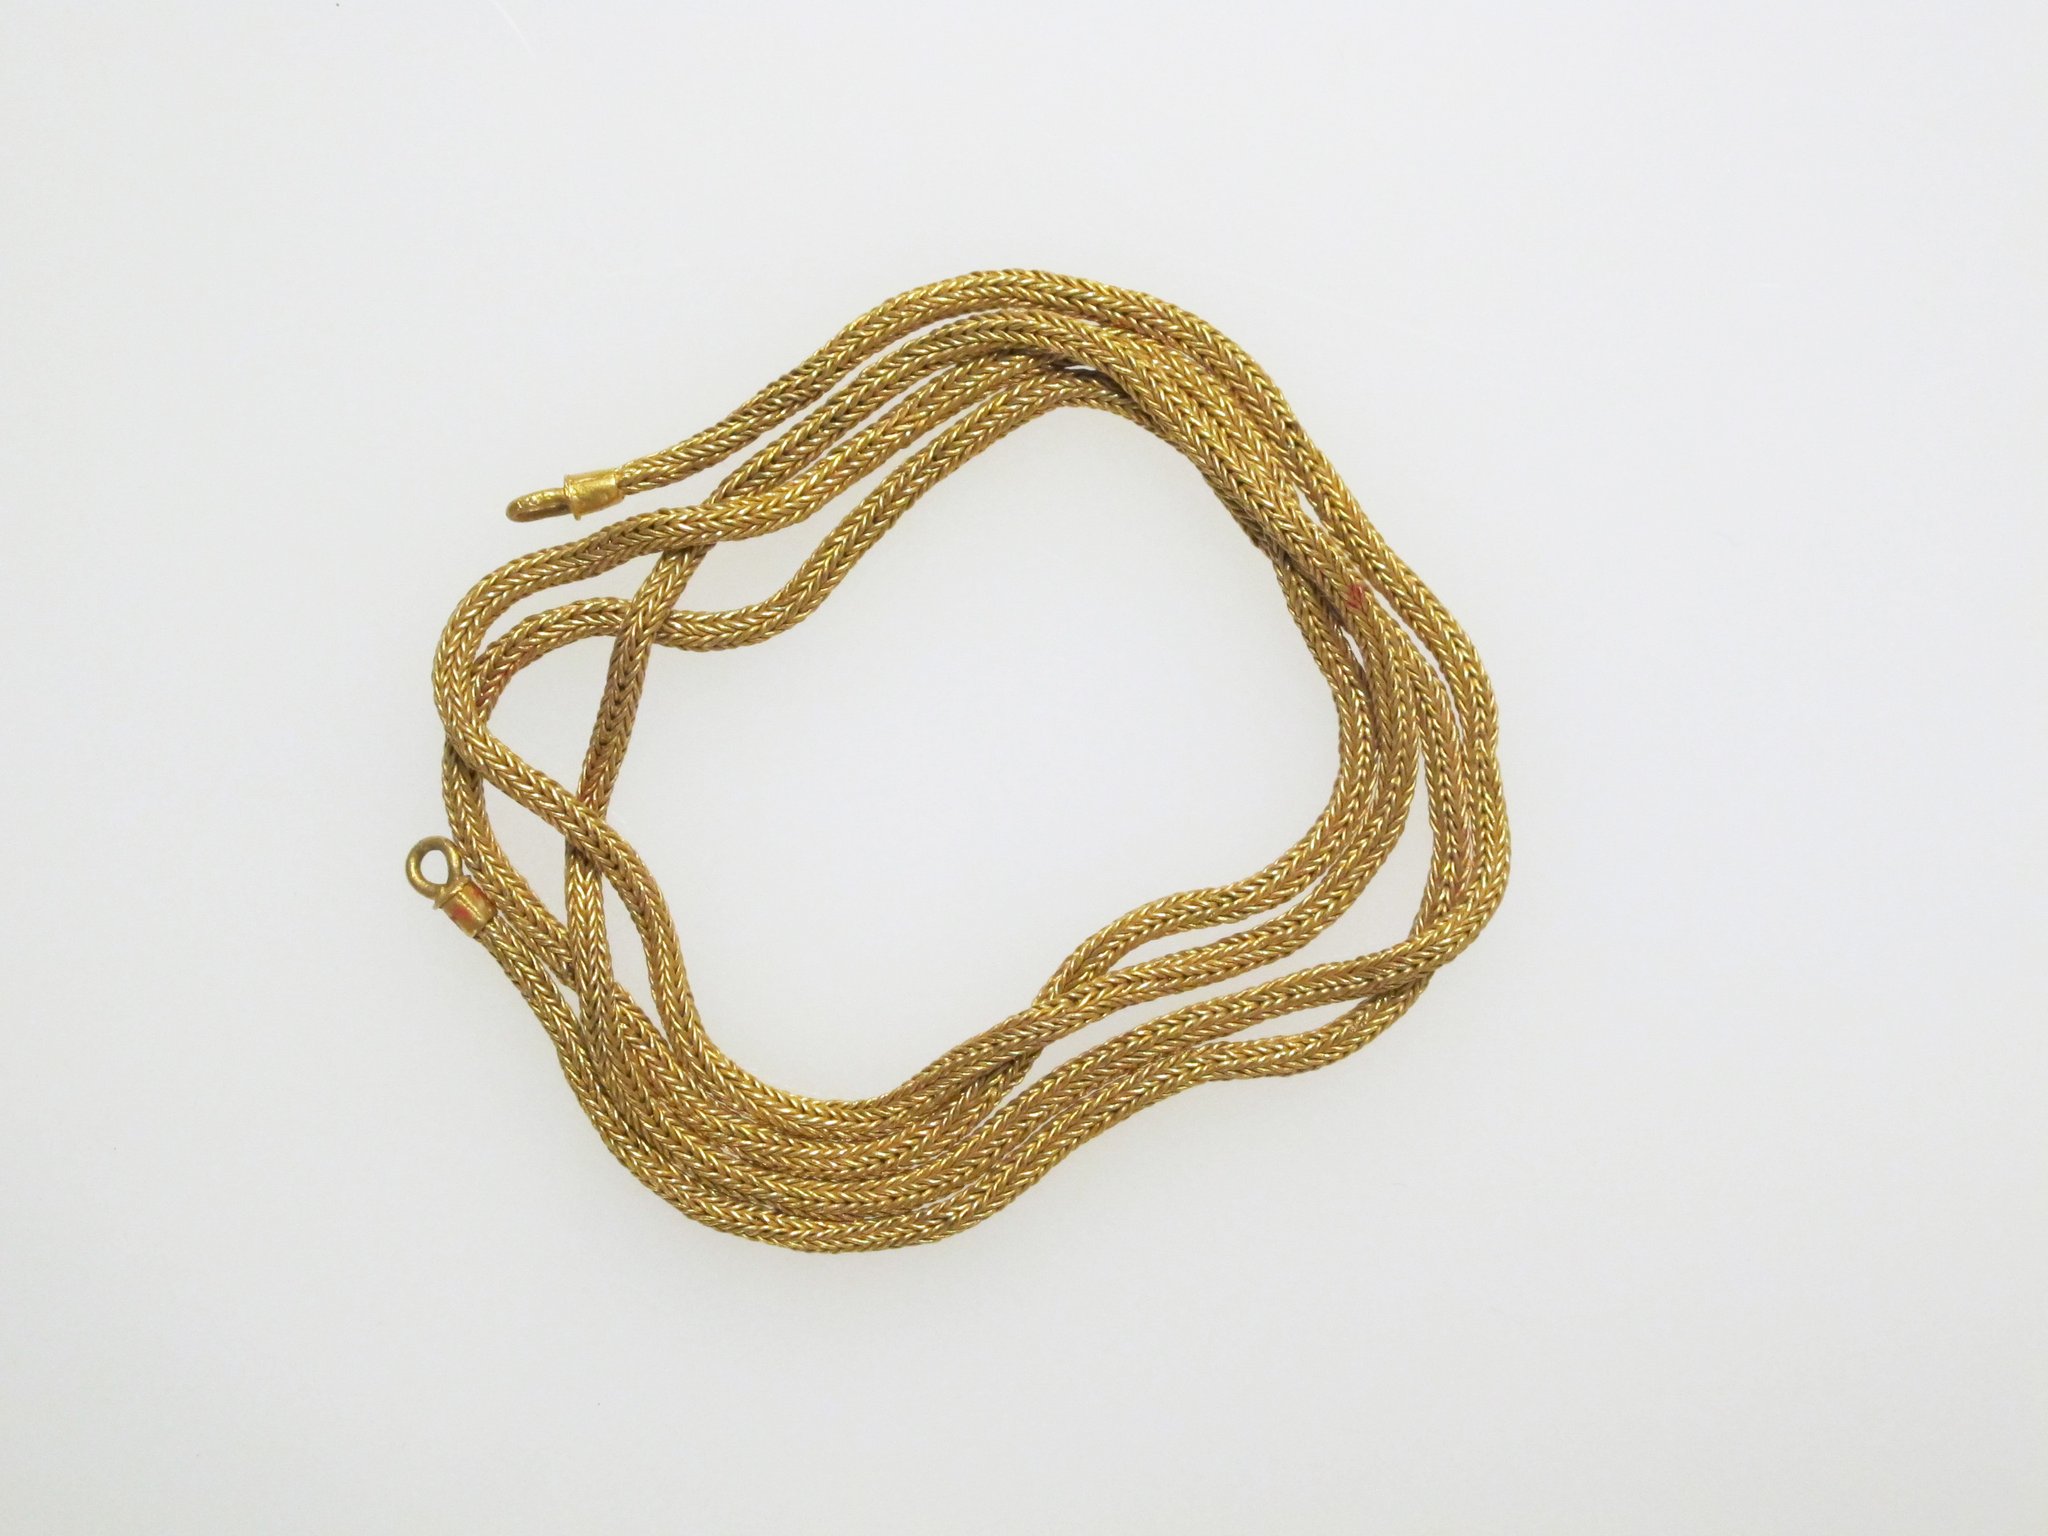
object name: chain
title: Gold chain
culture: roman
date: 670 BCE-330 CE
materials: gold